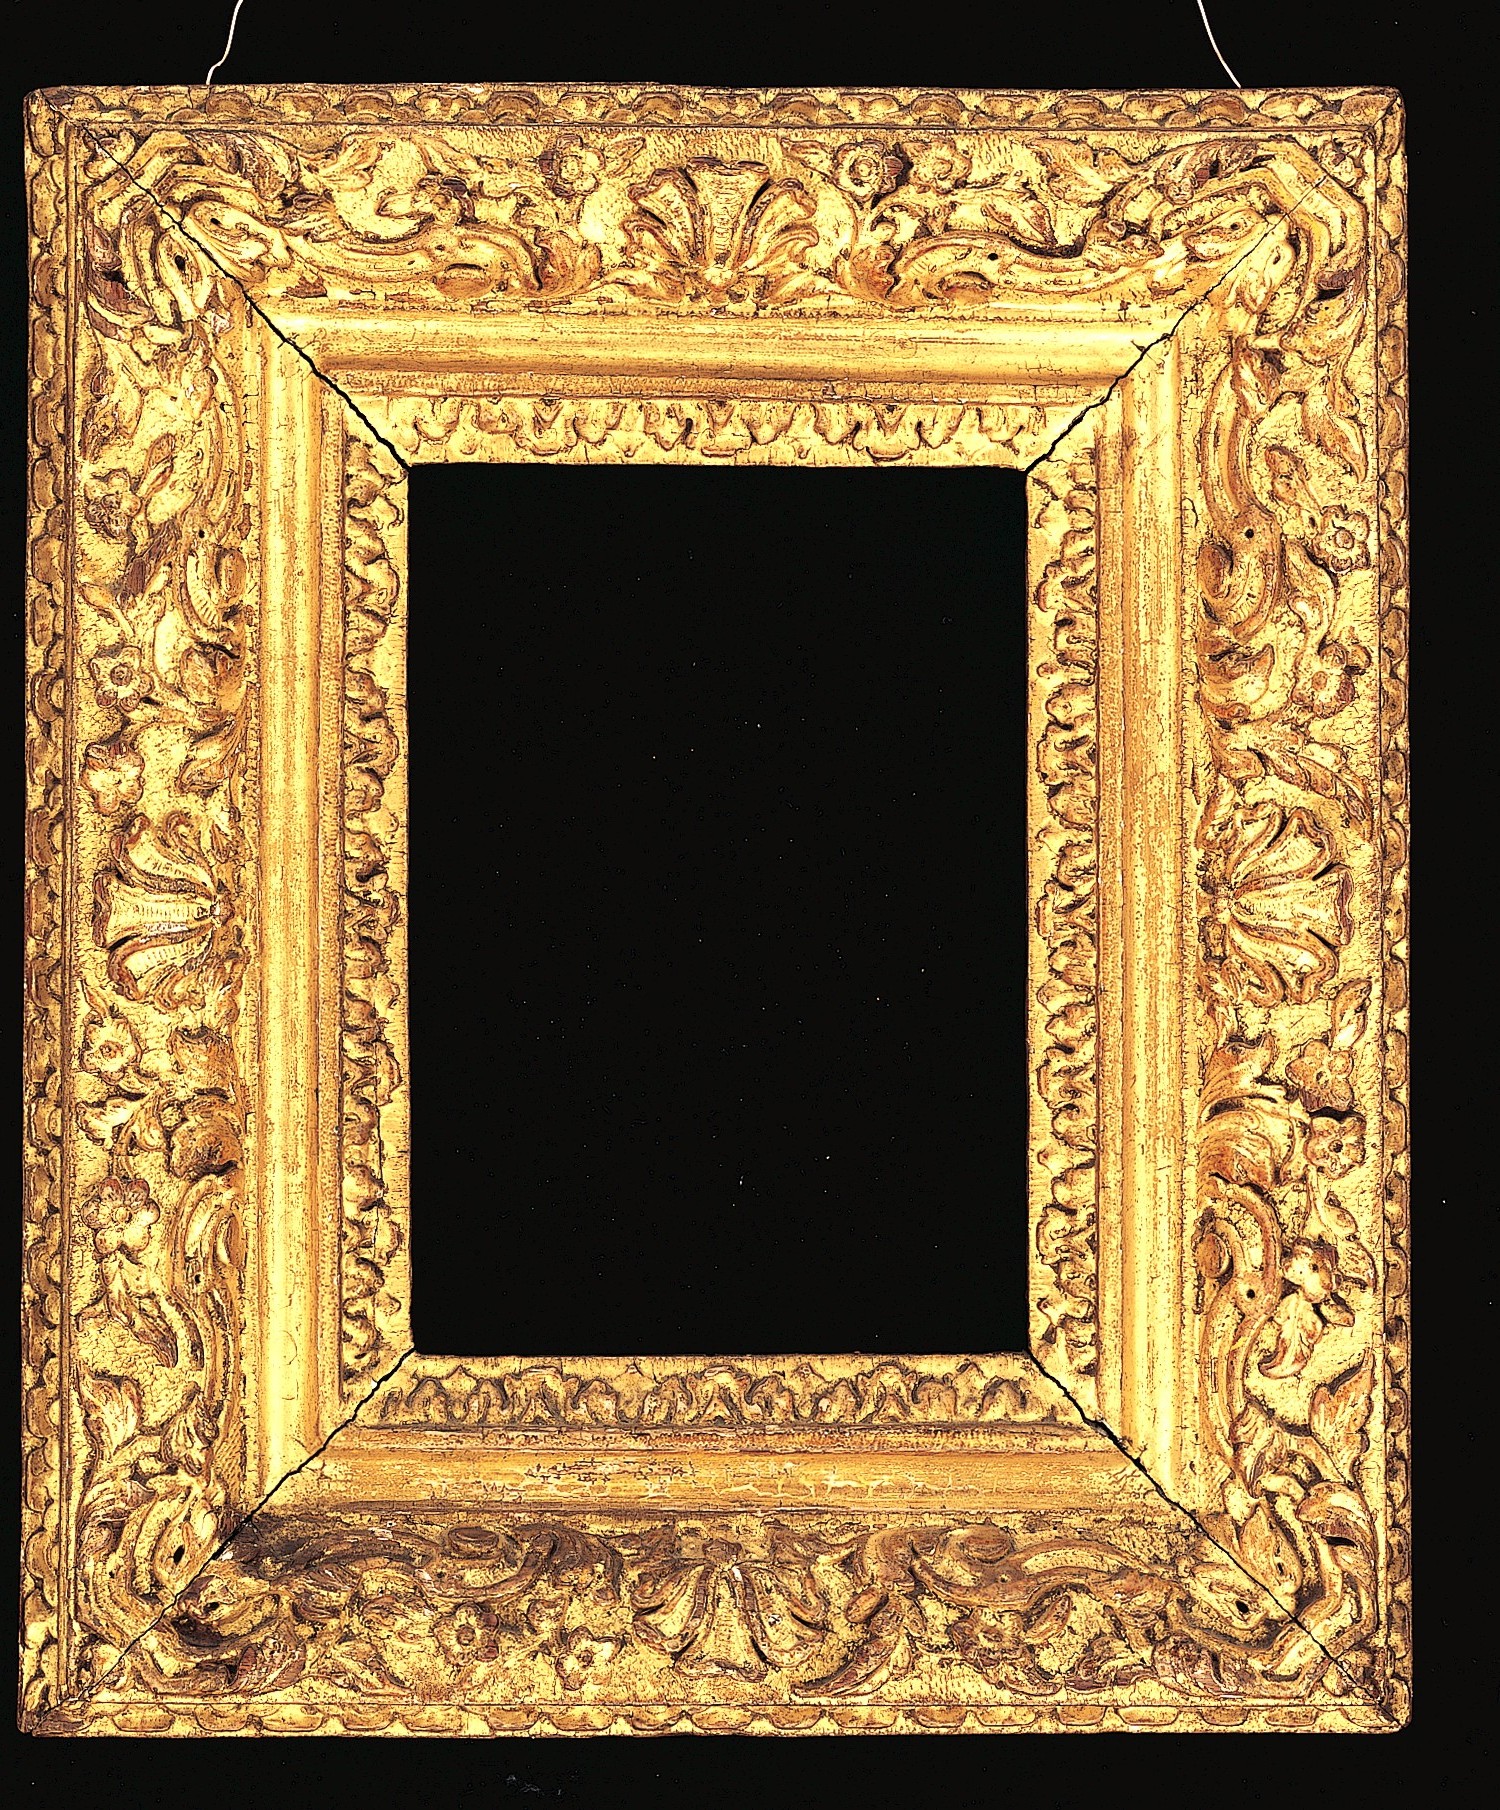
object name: frame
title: Ovolo frame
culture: french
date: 1660-1680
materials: wood